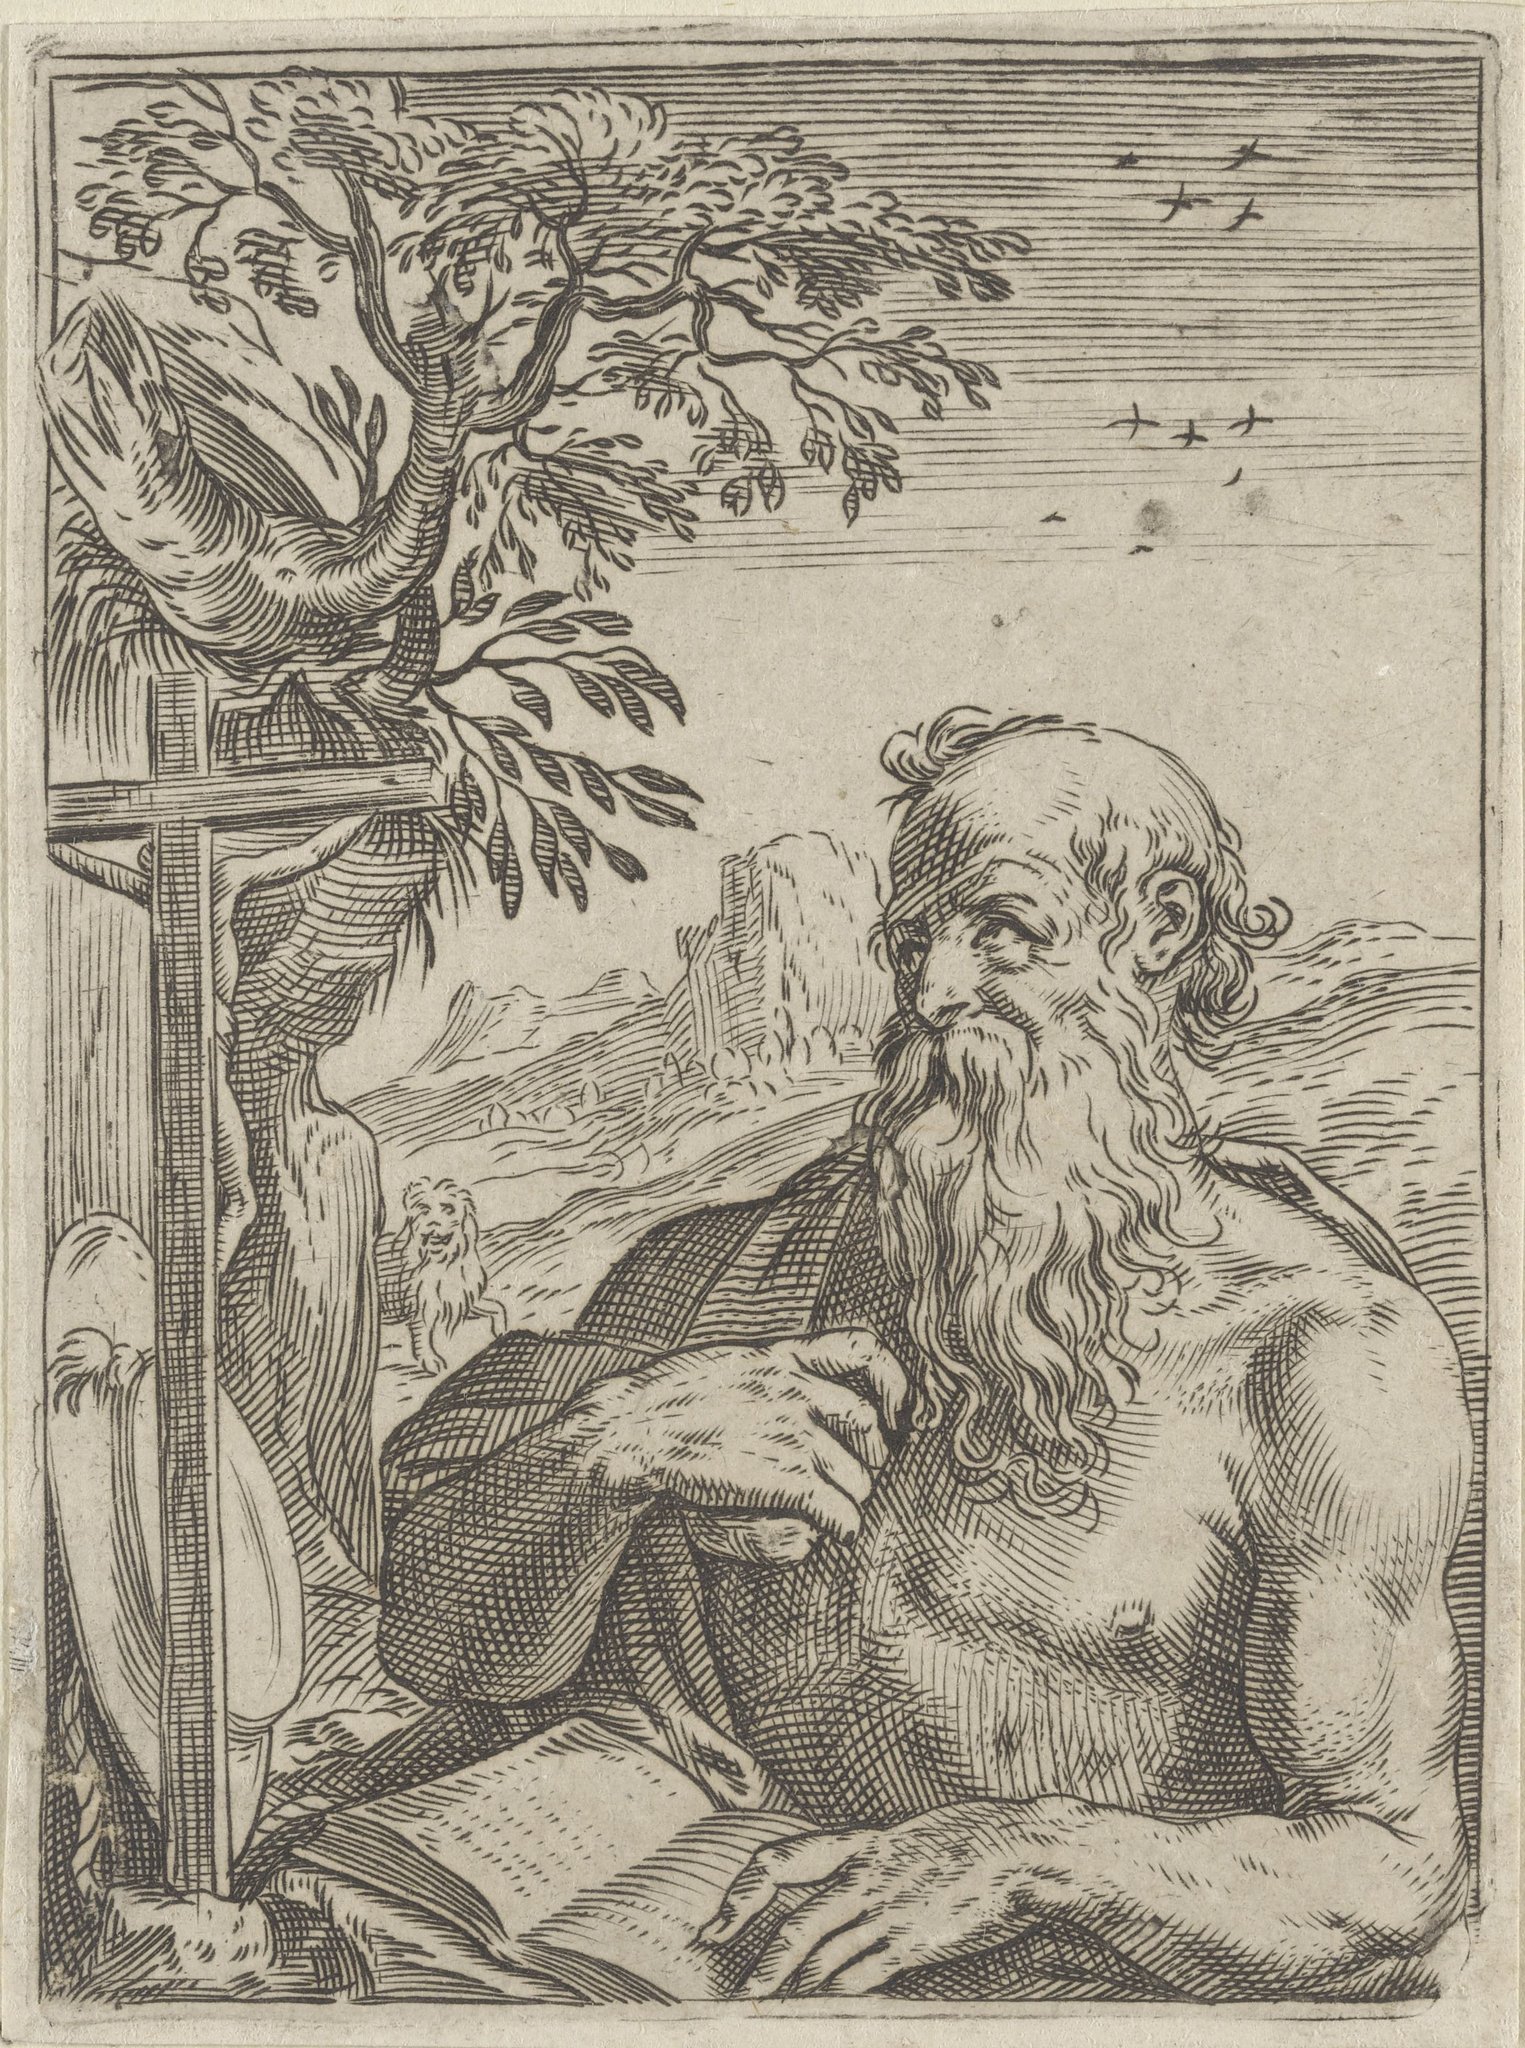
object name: print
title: Heilige Hieronymus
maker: agostino carracci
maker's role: draughtsman, painter, print maker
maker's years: 1557-1602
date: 1567-1602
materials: paper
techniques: engraving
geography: italy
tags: the monk and hermit jerome (hieronymus); possible attributes: book, cardinal's hat, crucifix, hour-glass, lion, skull, stone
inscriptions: collector's mark: Lugt 240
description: De heilige Hieronymus in gebed voor een crucifix. Voor hem liggen een boek en zijn kardinaalshoed. Op de achtergrond een leeuw in een landschap.